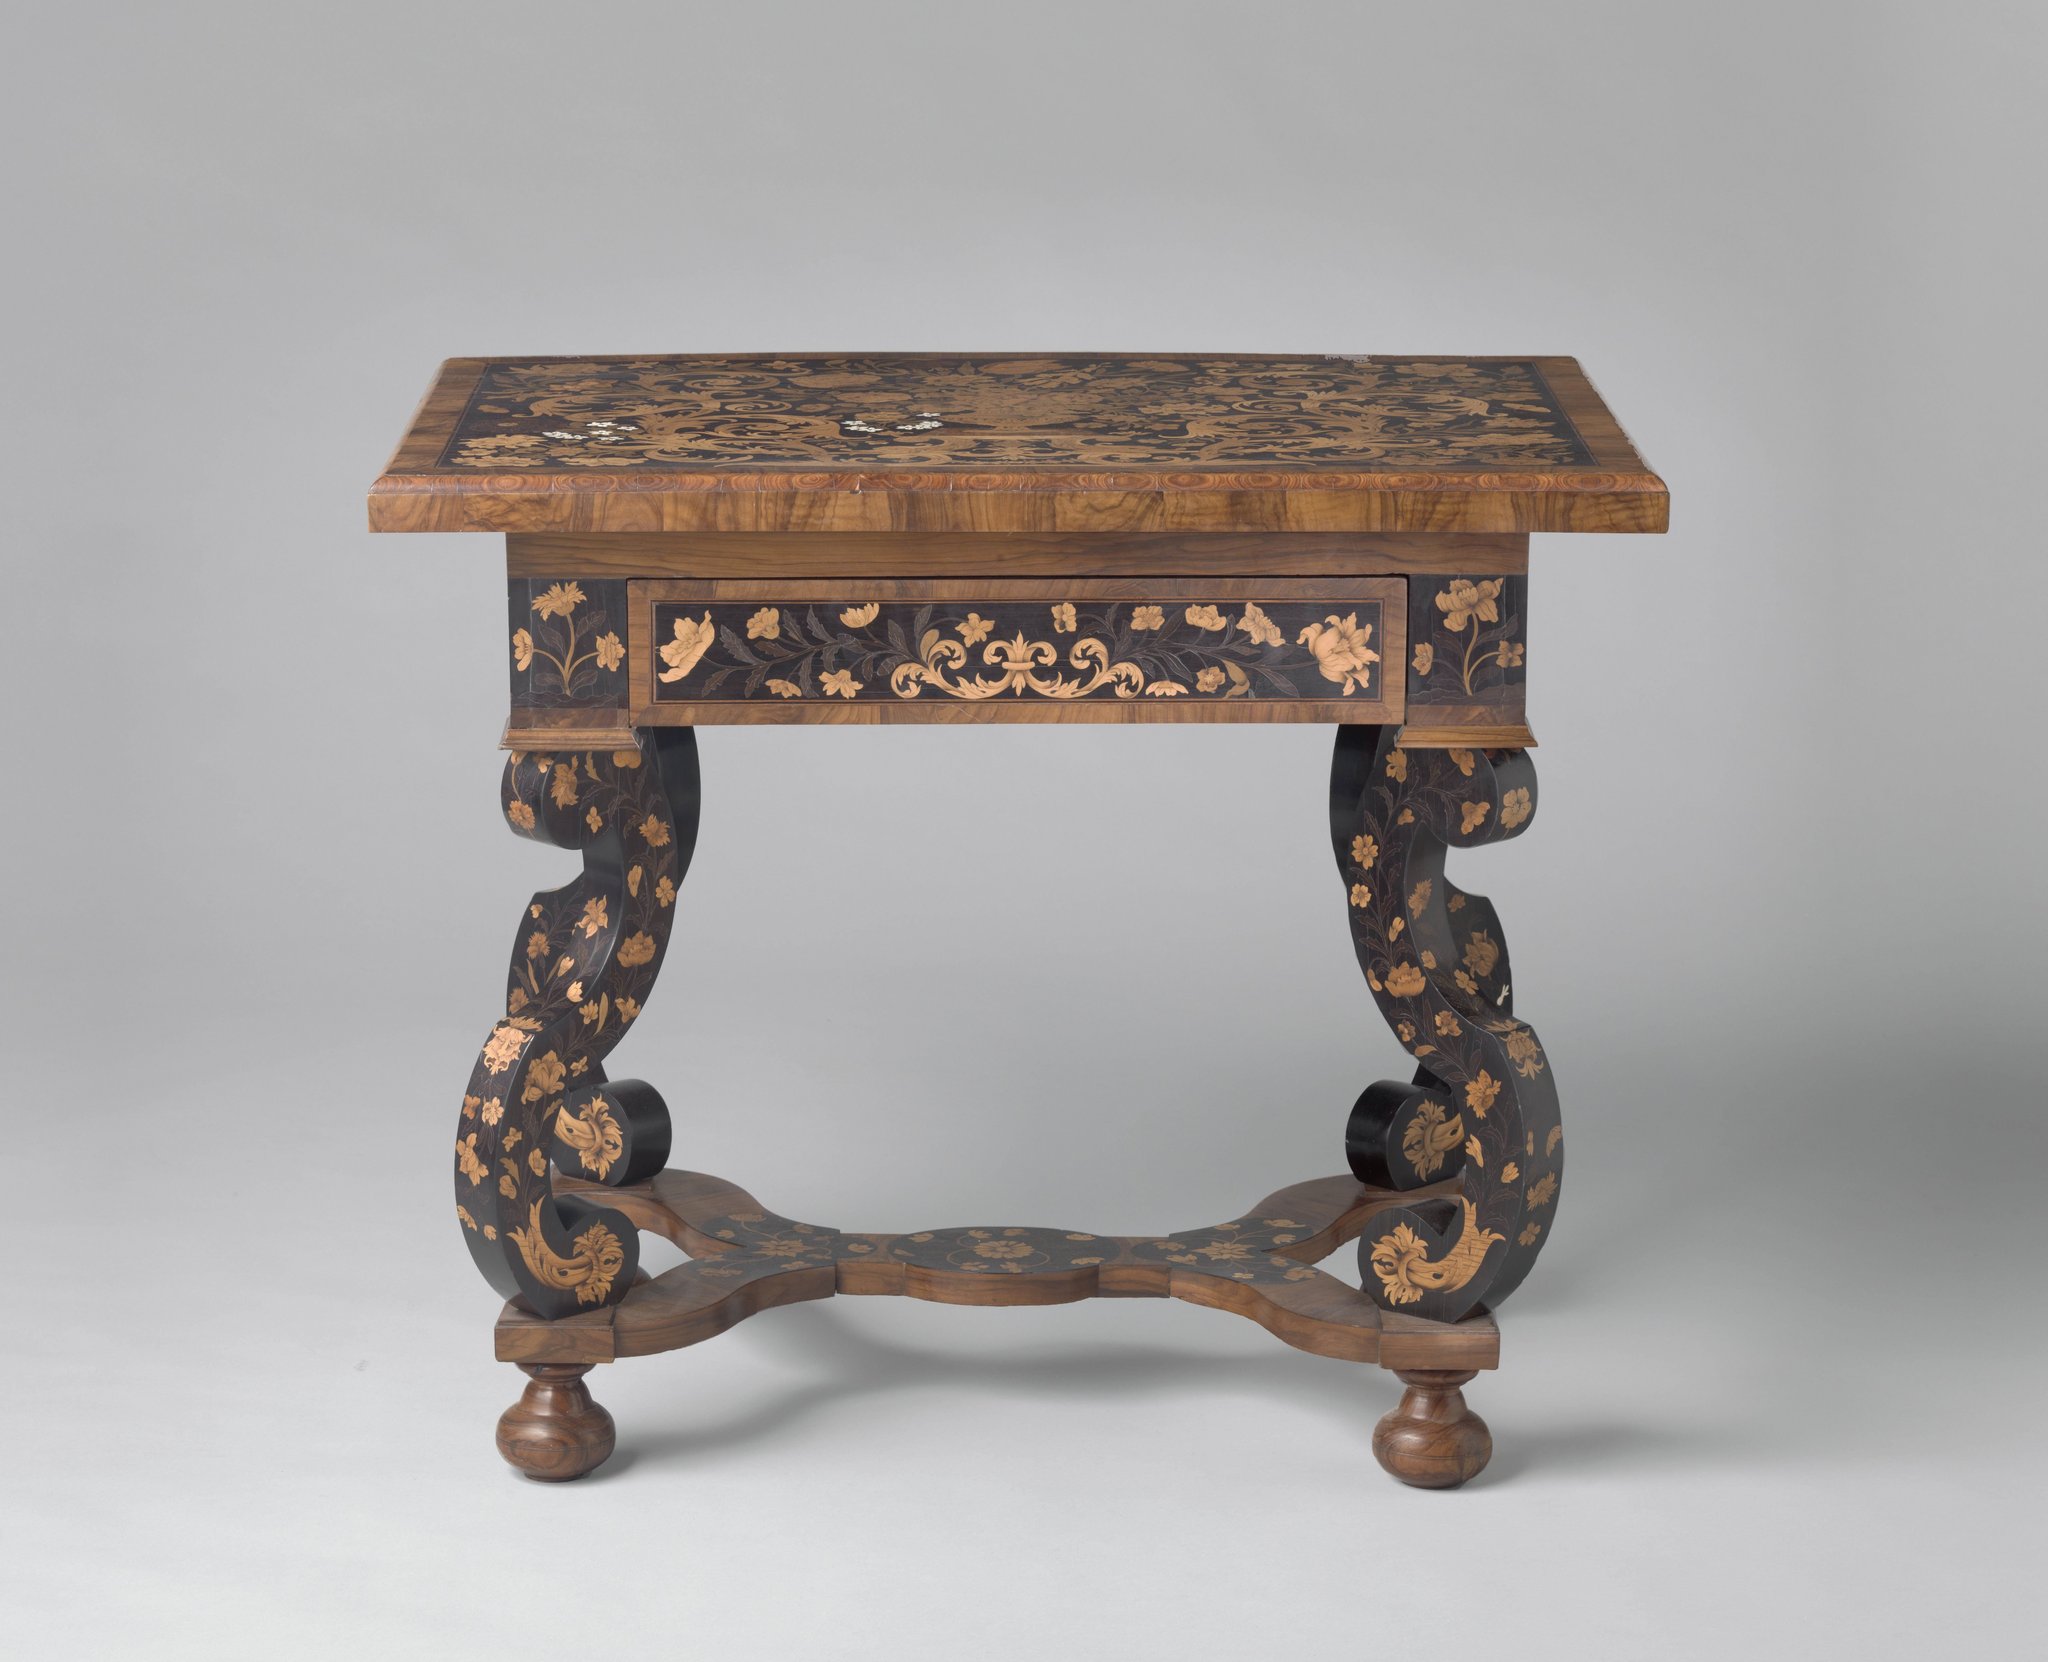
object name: furniture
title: Table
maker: Anonymous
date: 1685-1700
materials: bone, wood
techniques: veneer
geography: northern netherlands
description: This table would typically have been placed against a wall, with a mirror above it, and candle stands on either side. It was often paired with a matching cabinet decorated with flowers made of different coloured woods. This coordinated design created unity in the interior.